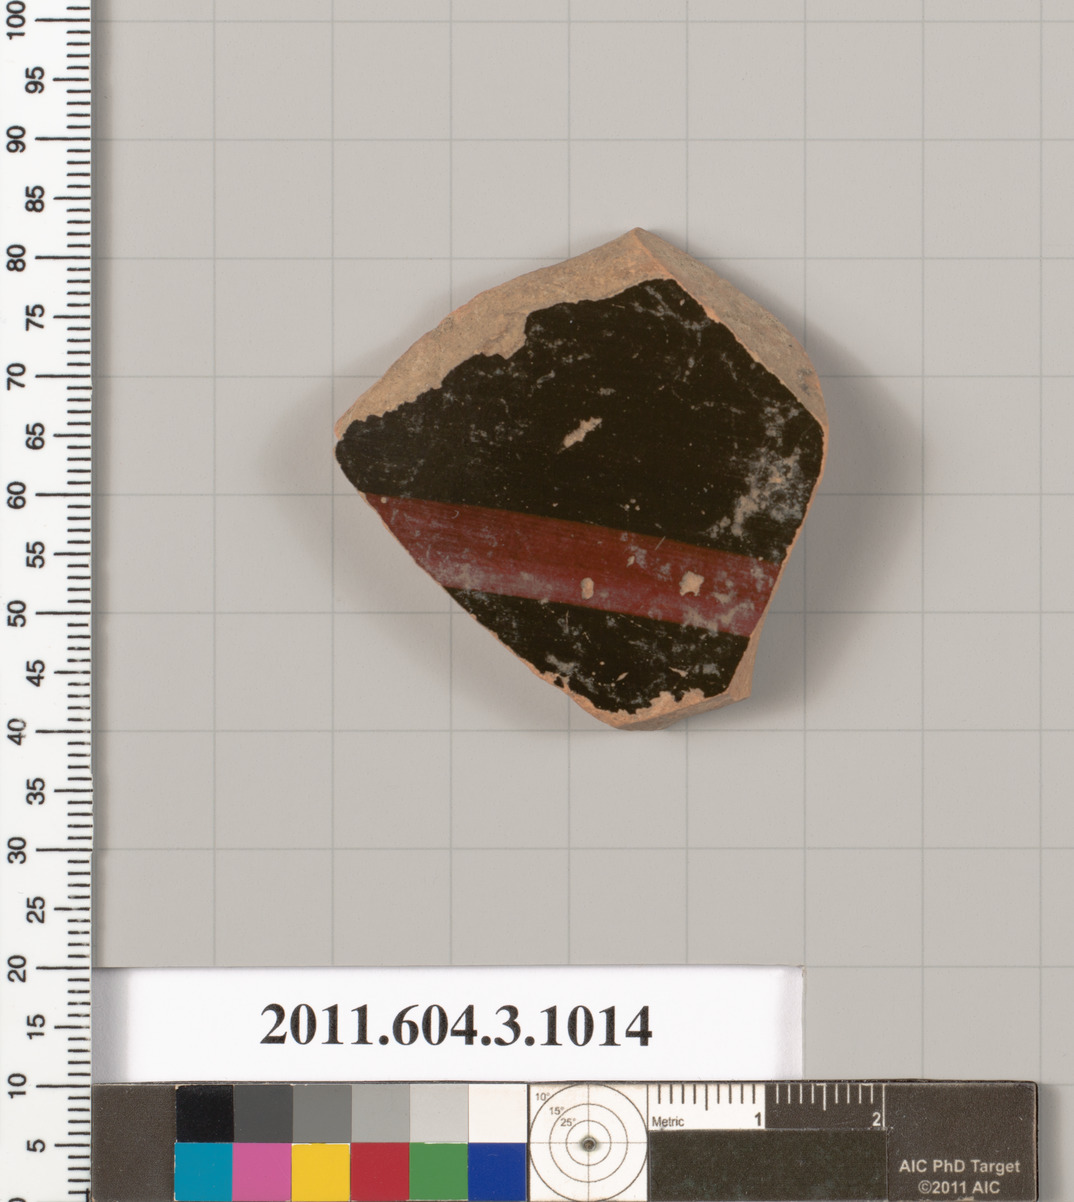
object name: lekanis fragment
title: Terracotta fragment of a lekanis (covered dish)?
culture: greek, attic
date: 600-501 BCE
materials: terracotta